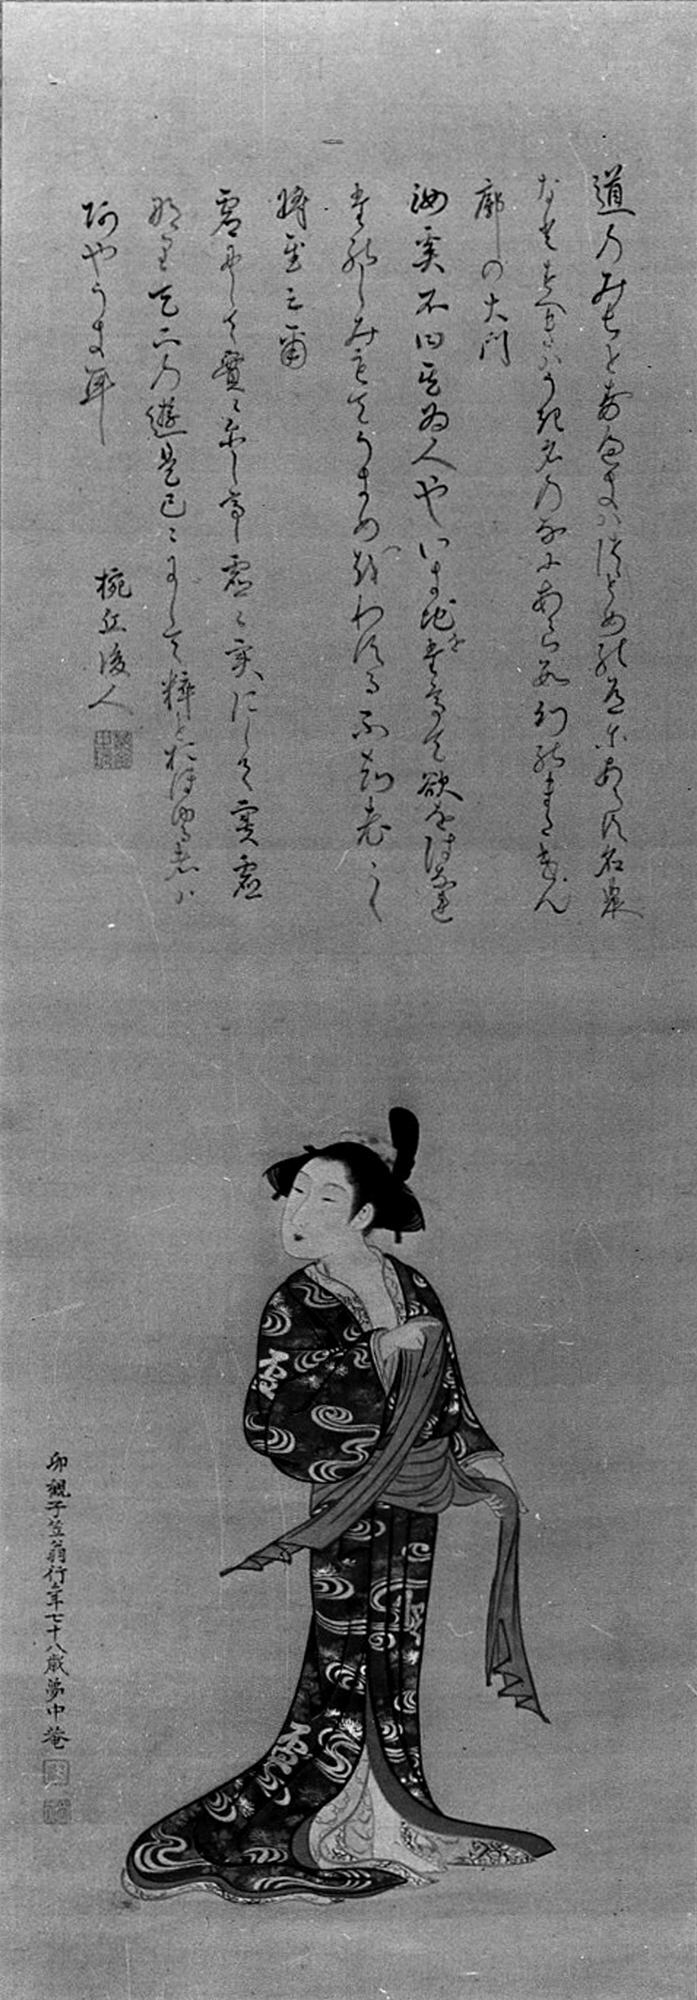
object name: hanging scroll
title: Girl Tying Sash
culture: japanese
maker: ogawa haritsu (ritsuō)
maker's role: artist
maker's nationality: japanese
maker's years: 1663-1747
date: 1740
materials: ink, silk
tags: women